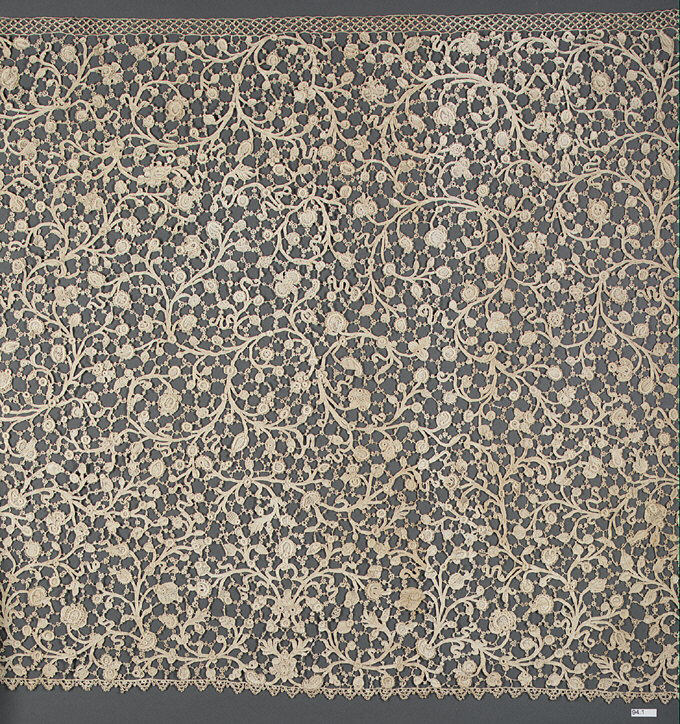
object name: flounce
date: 1700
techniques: lace